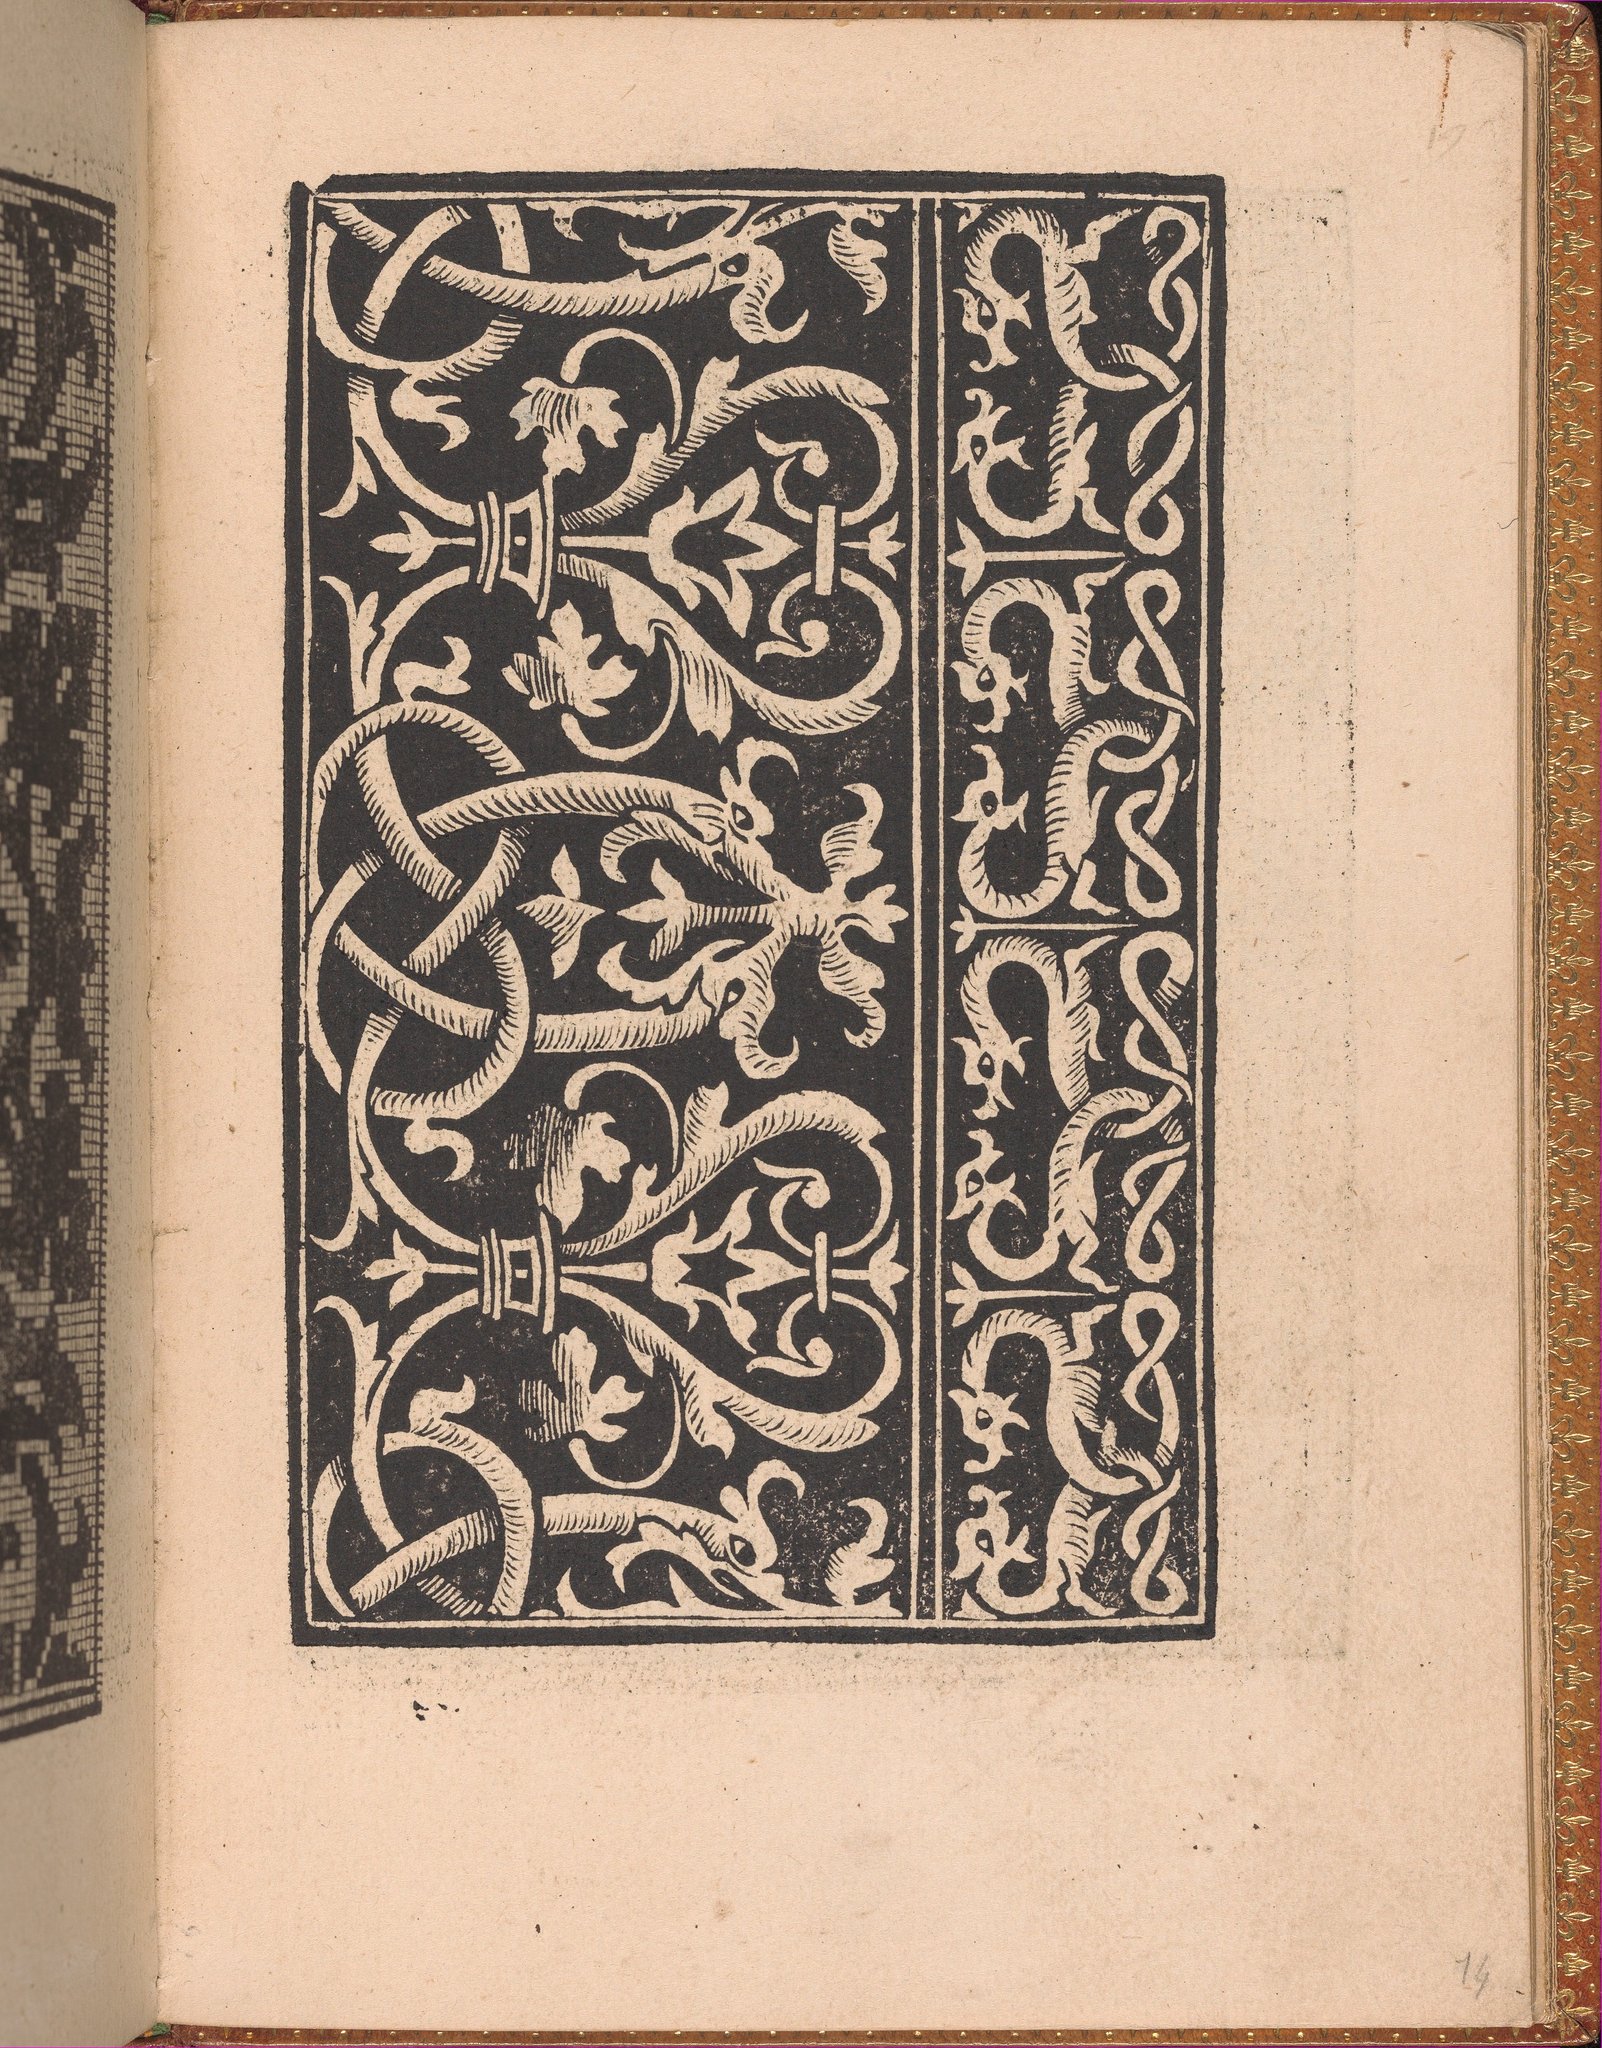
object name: book print ornament architecture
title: Convivio delle Belle Donne, page 14 (recto)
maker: nicolò zoppino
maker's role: publisher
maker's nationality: italian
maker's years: 1478-1544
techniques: woodcut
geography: italy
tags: ornament